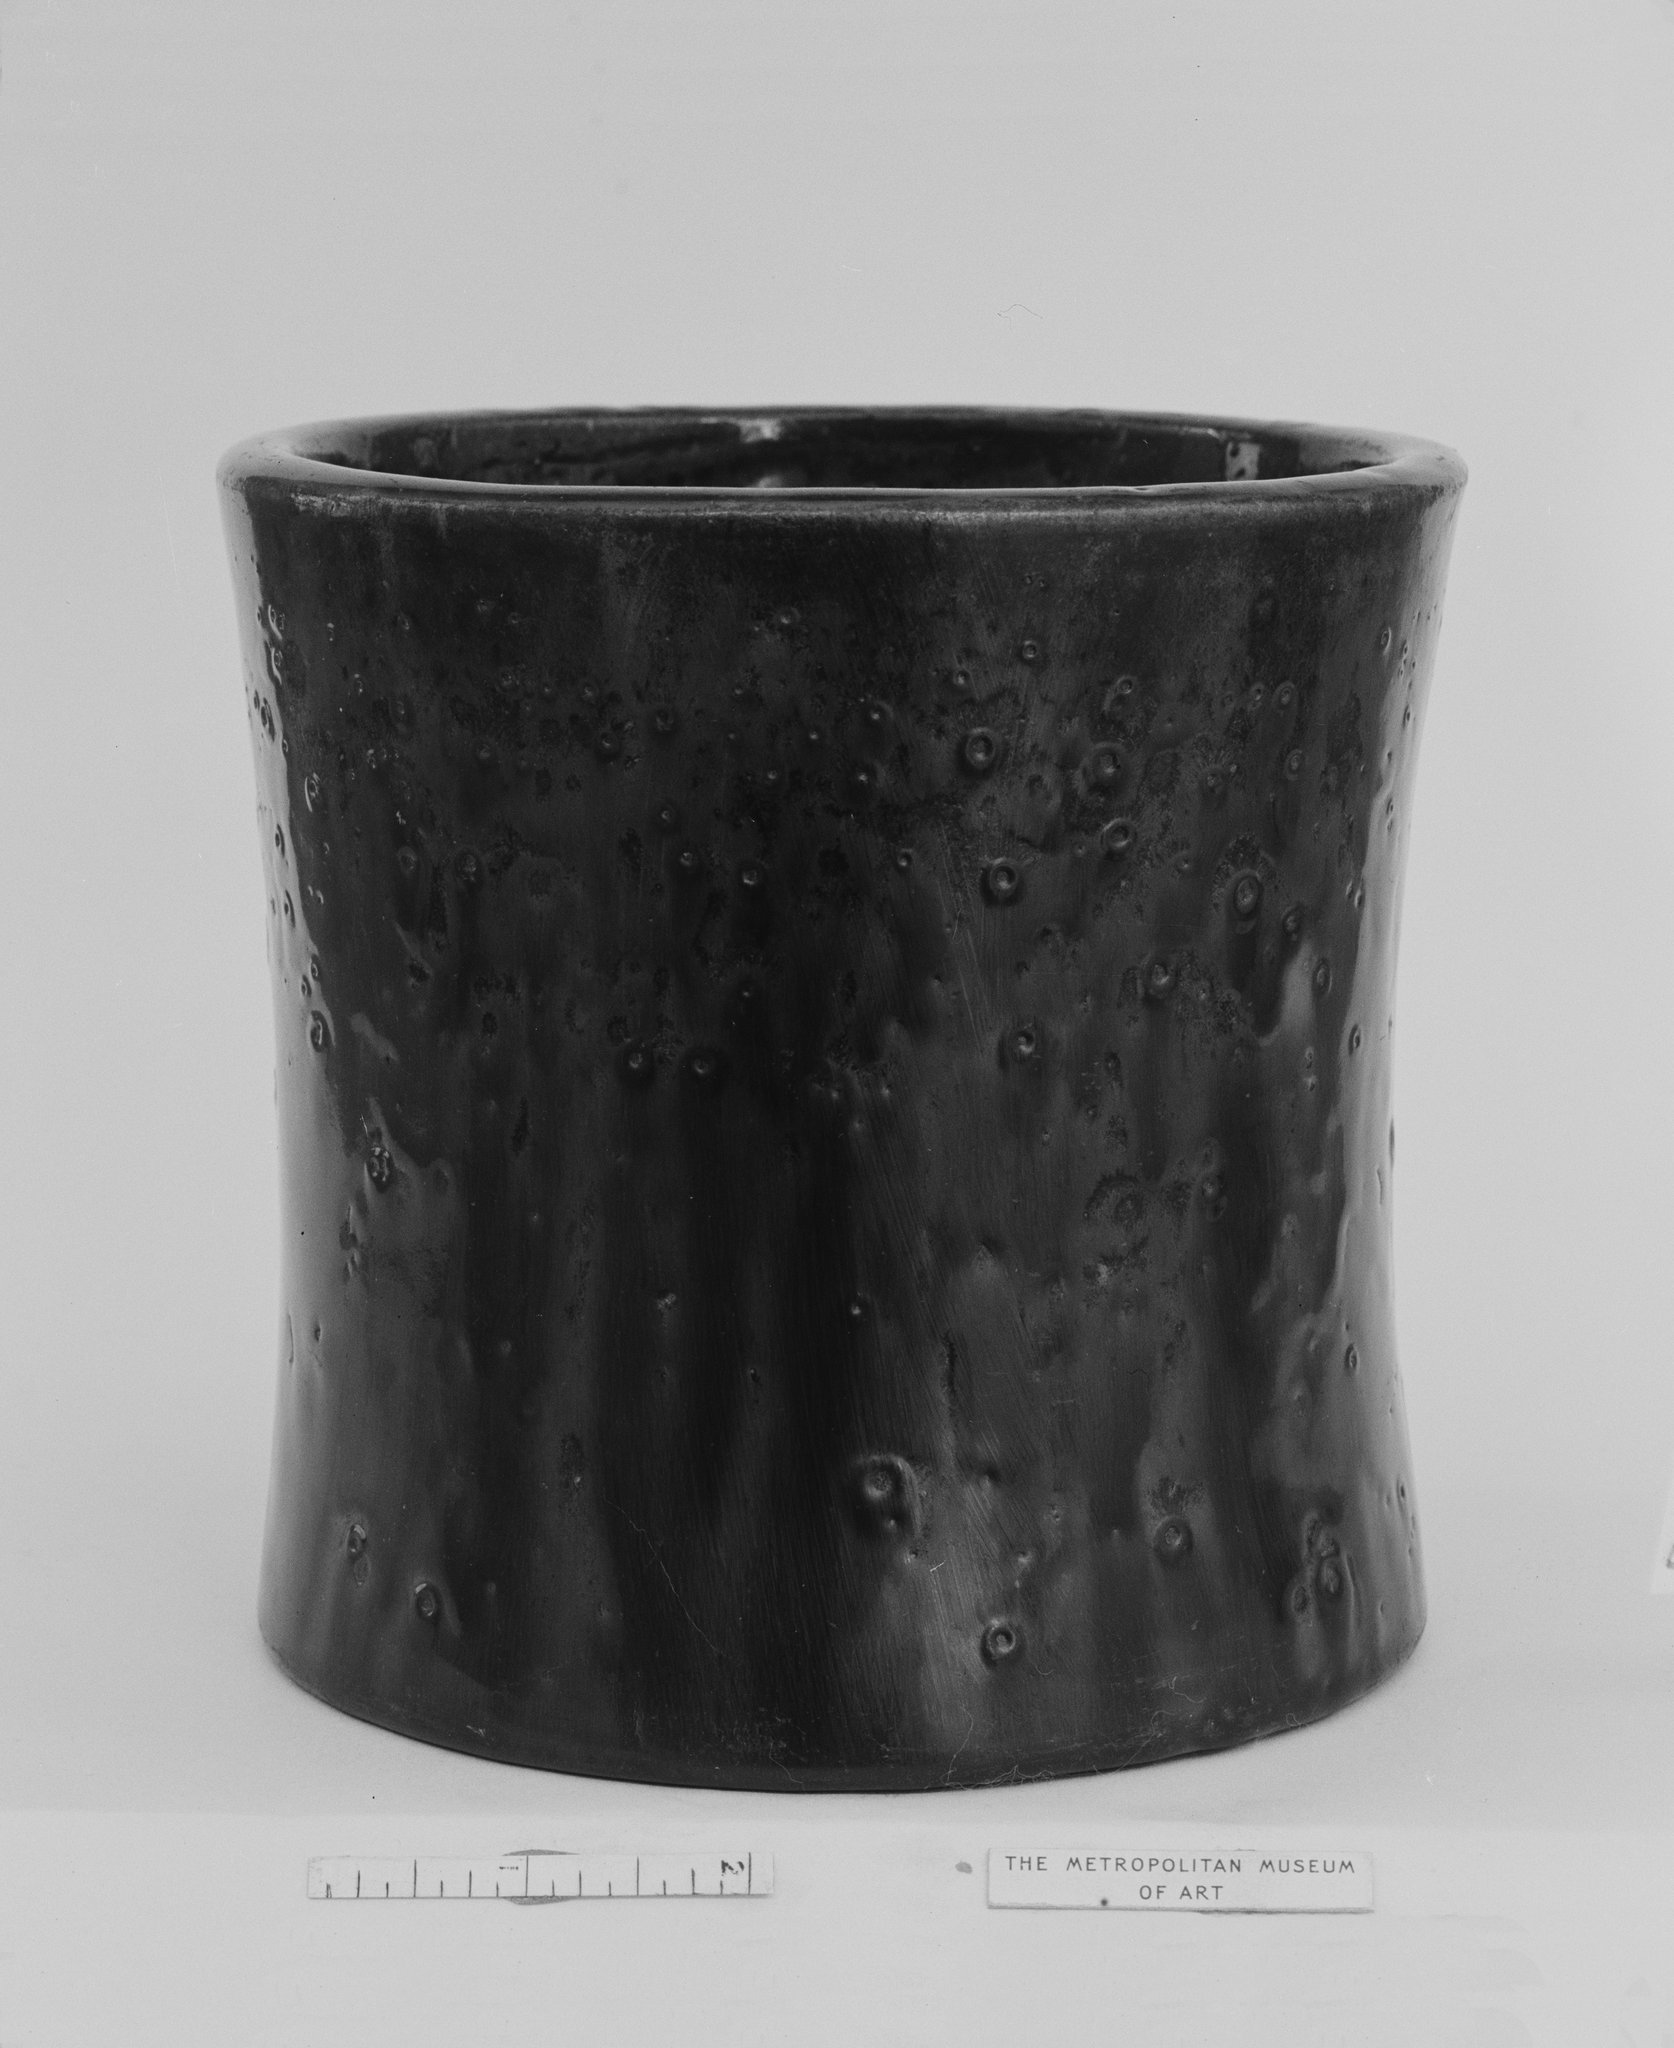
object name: brush pot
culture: japanese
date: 1701-1800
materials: clay, glaze